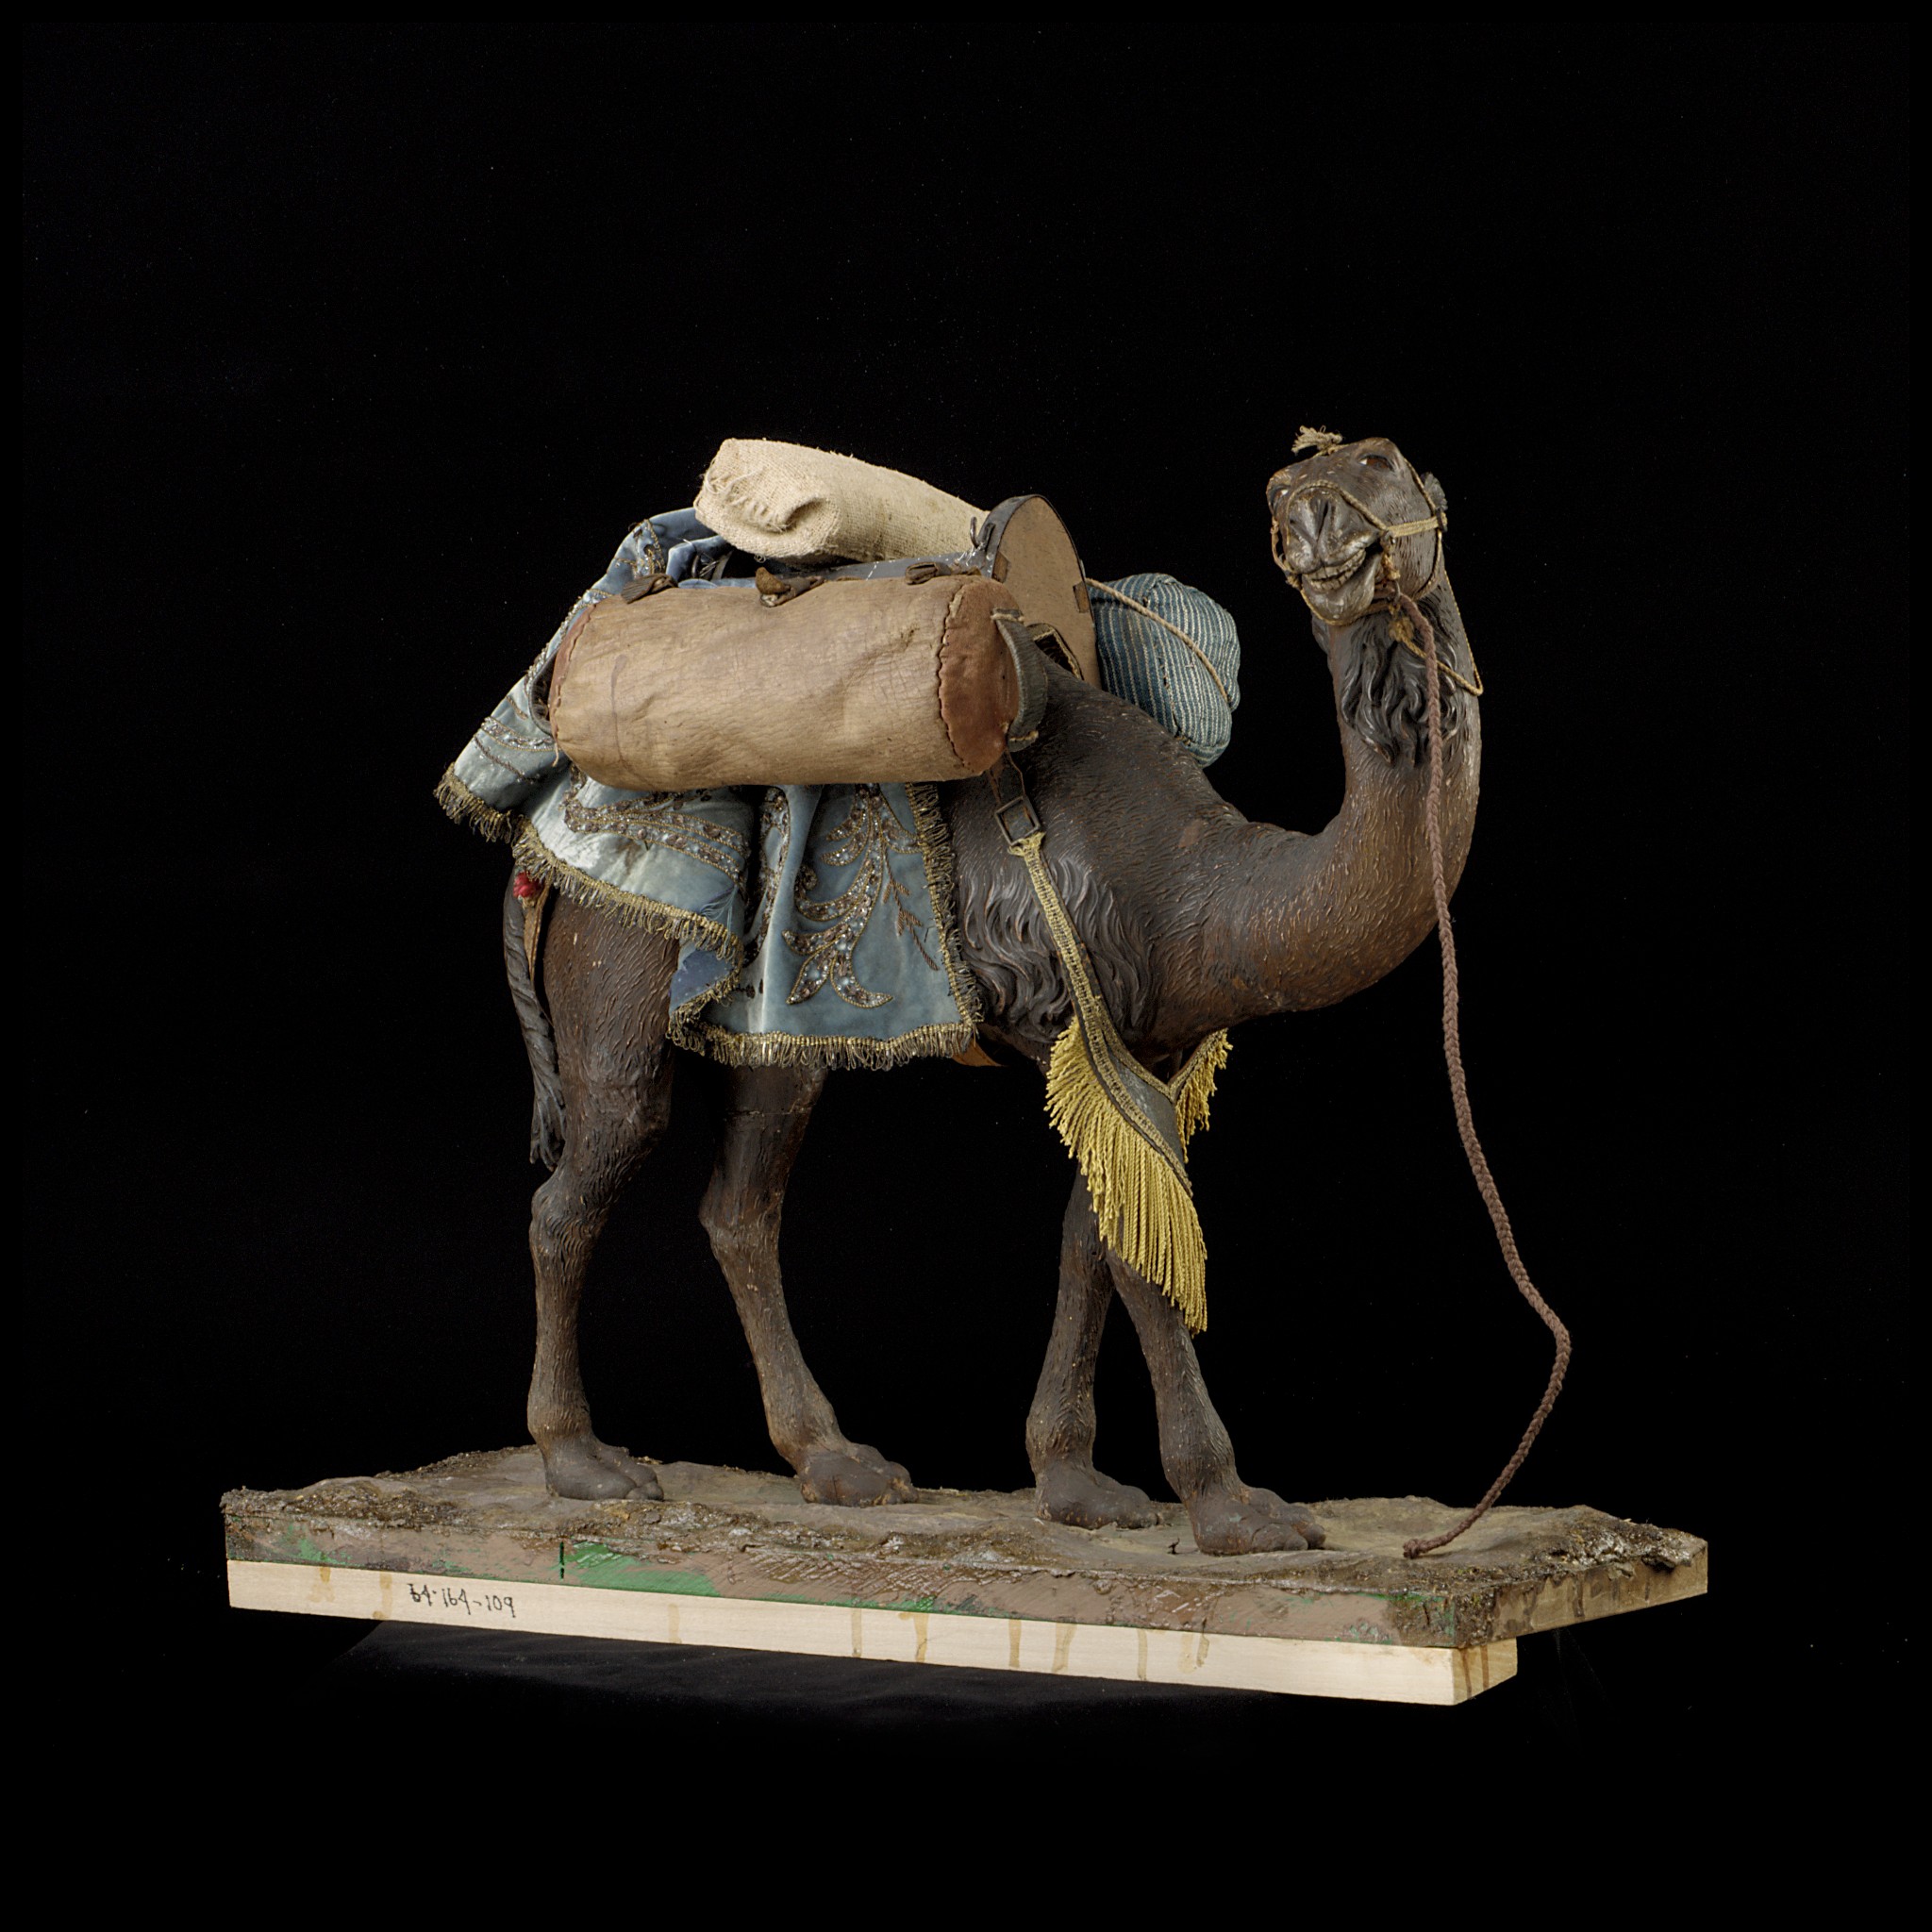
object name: crèche figure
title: Camel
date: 1751-1800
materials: leather, plaster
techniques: polychrome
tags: camels